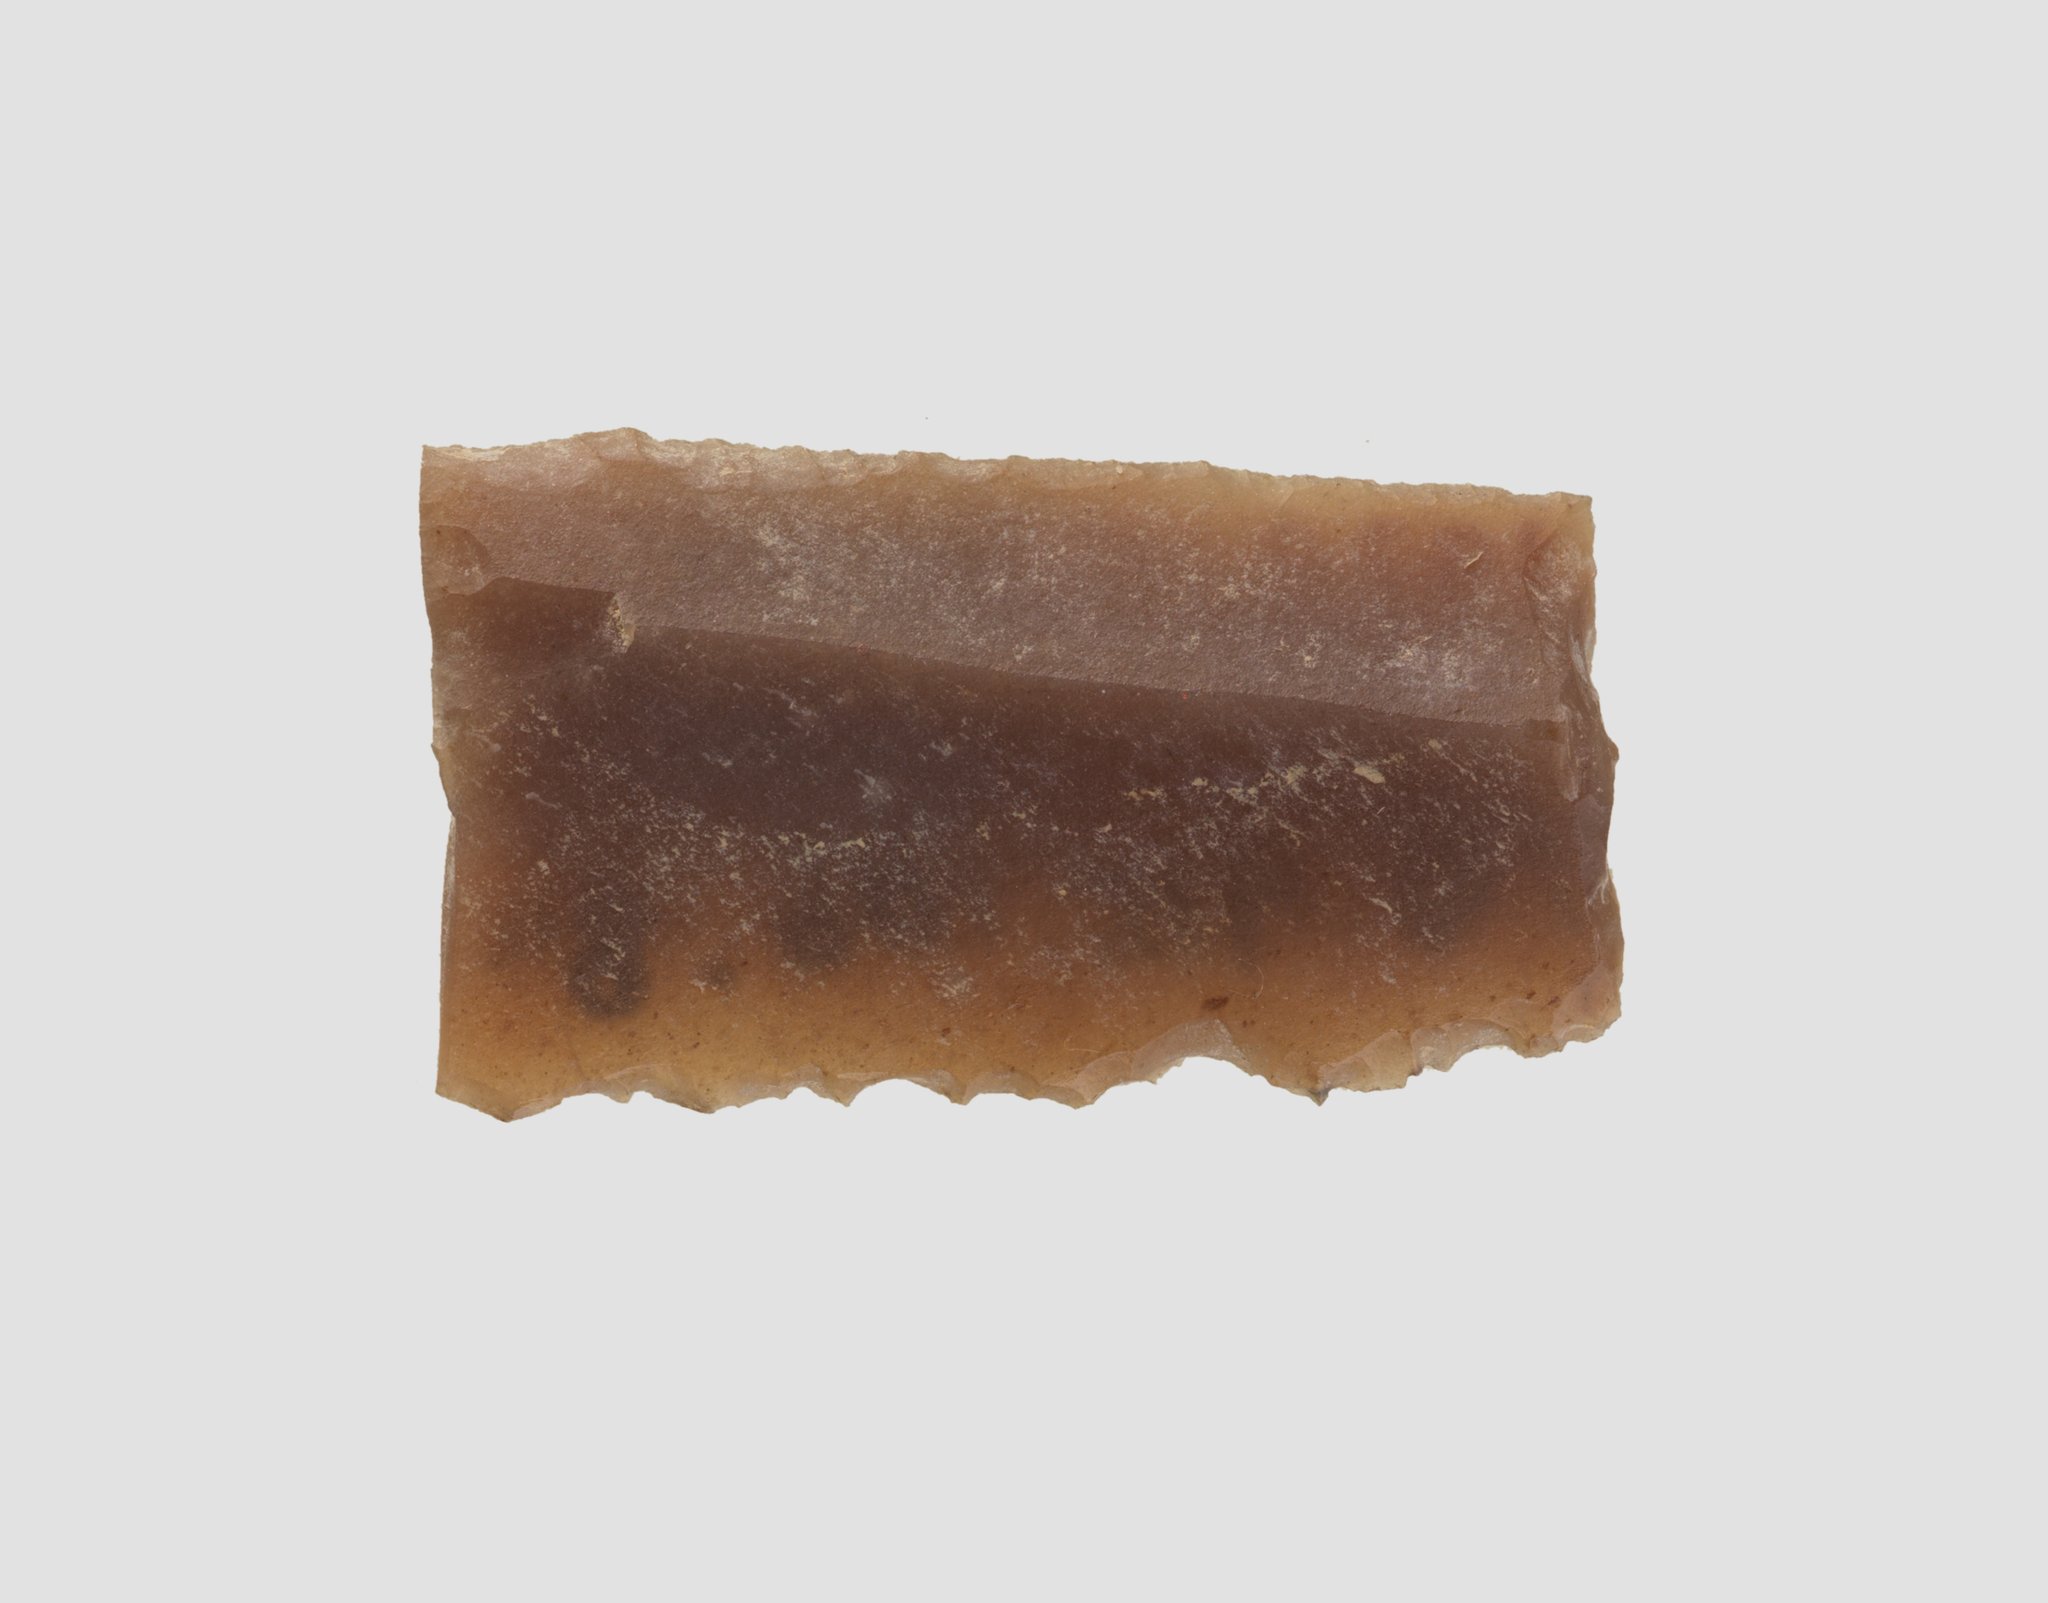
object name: knife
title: Blade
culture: ghassulian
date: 4600-3600 BCE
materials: stone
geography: levant